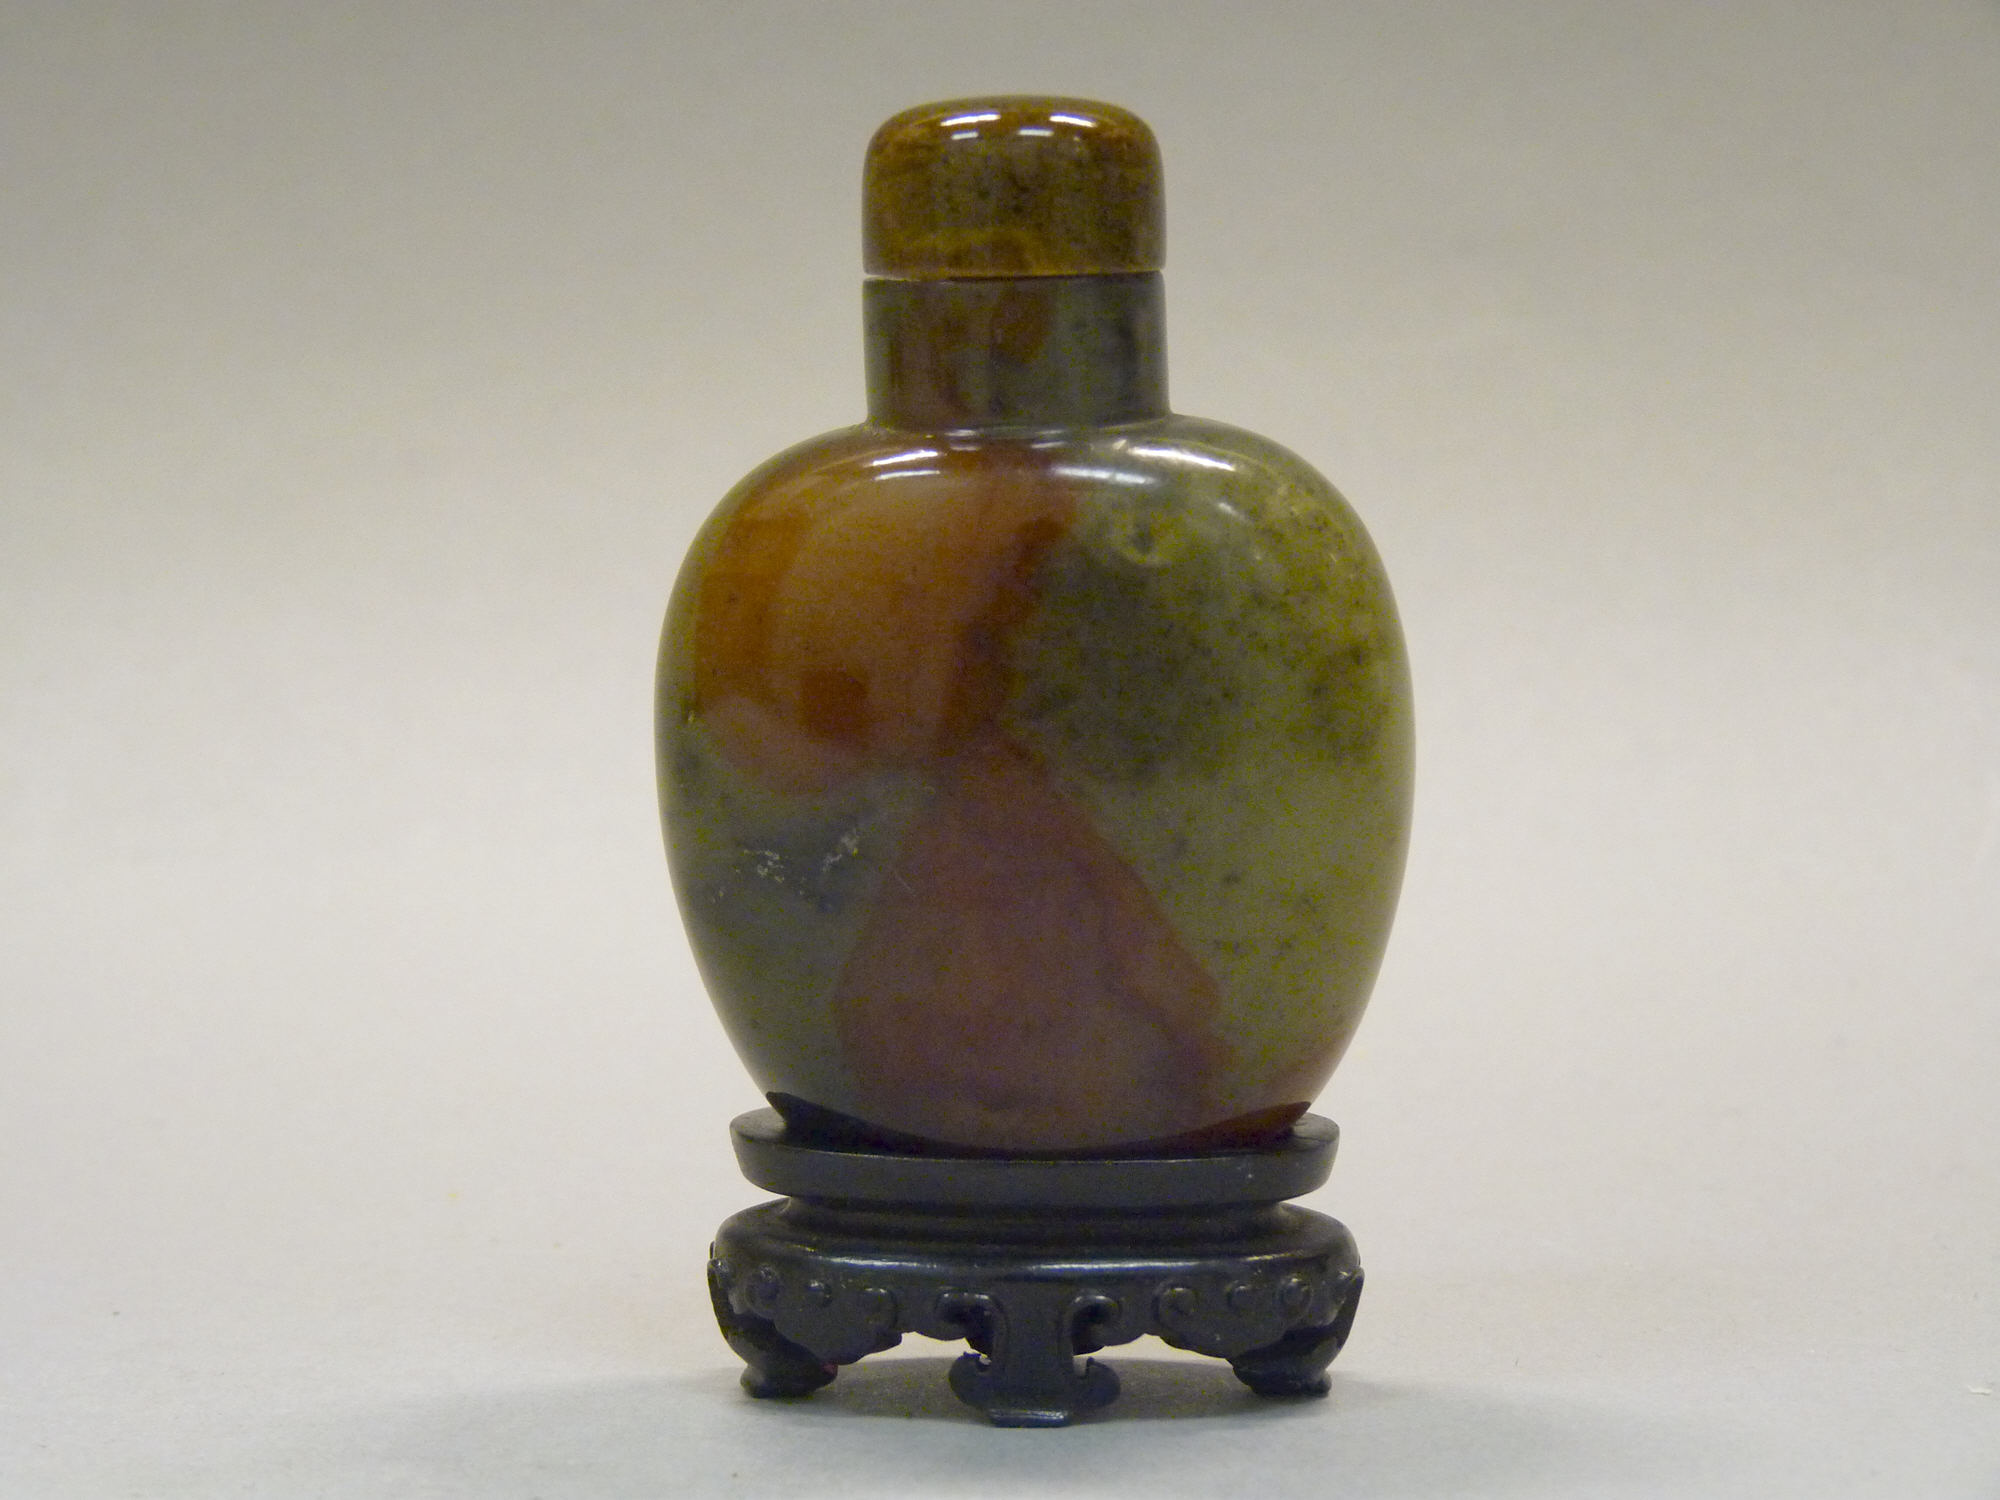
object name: snuff bottle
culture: chinese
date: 1736-1795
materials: stone